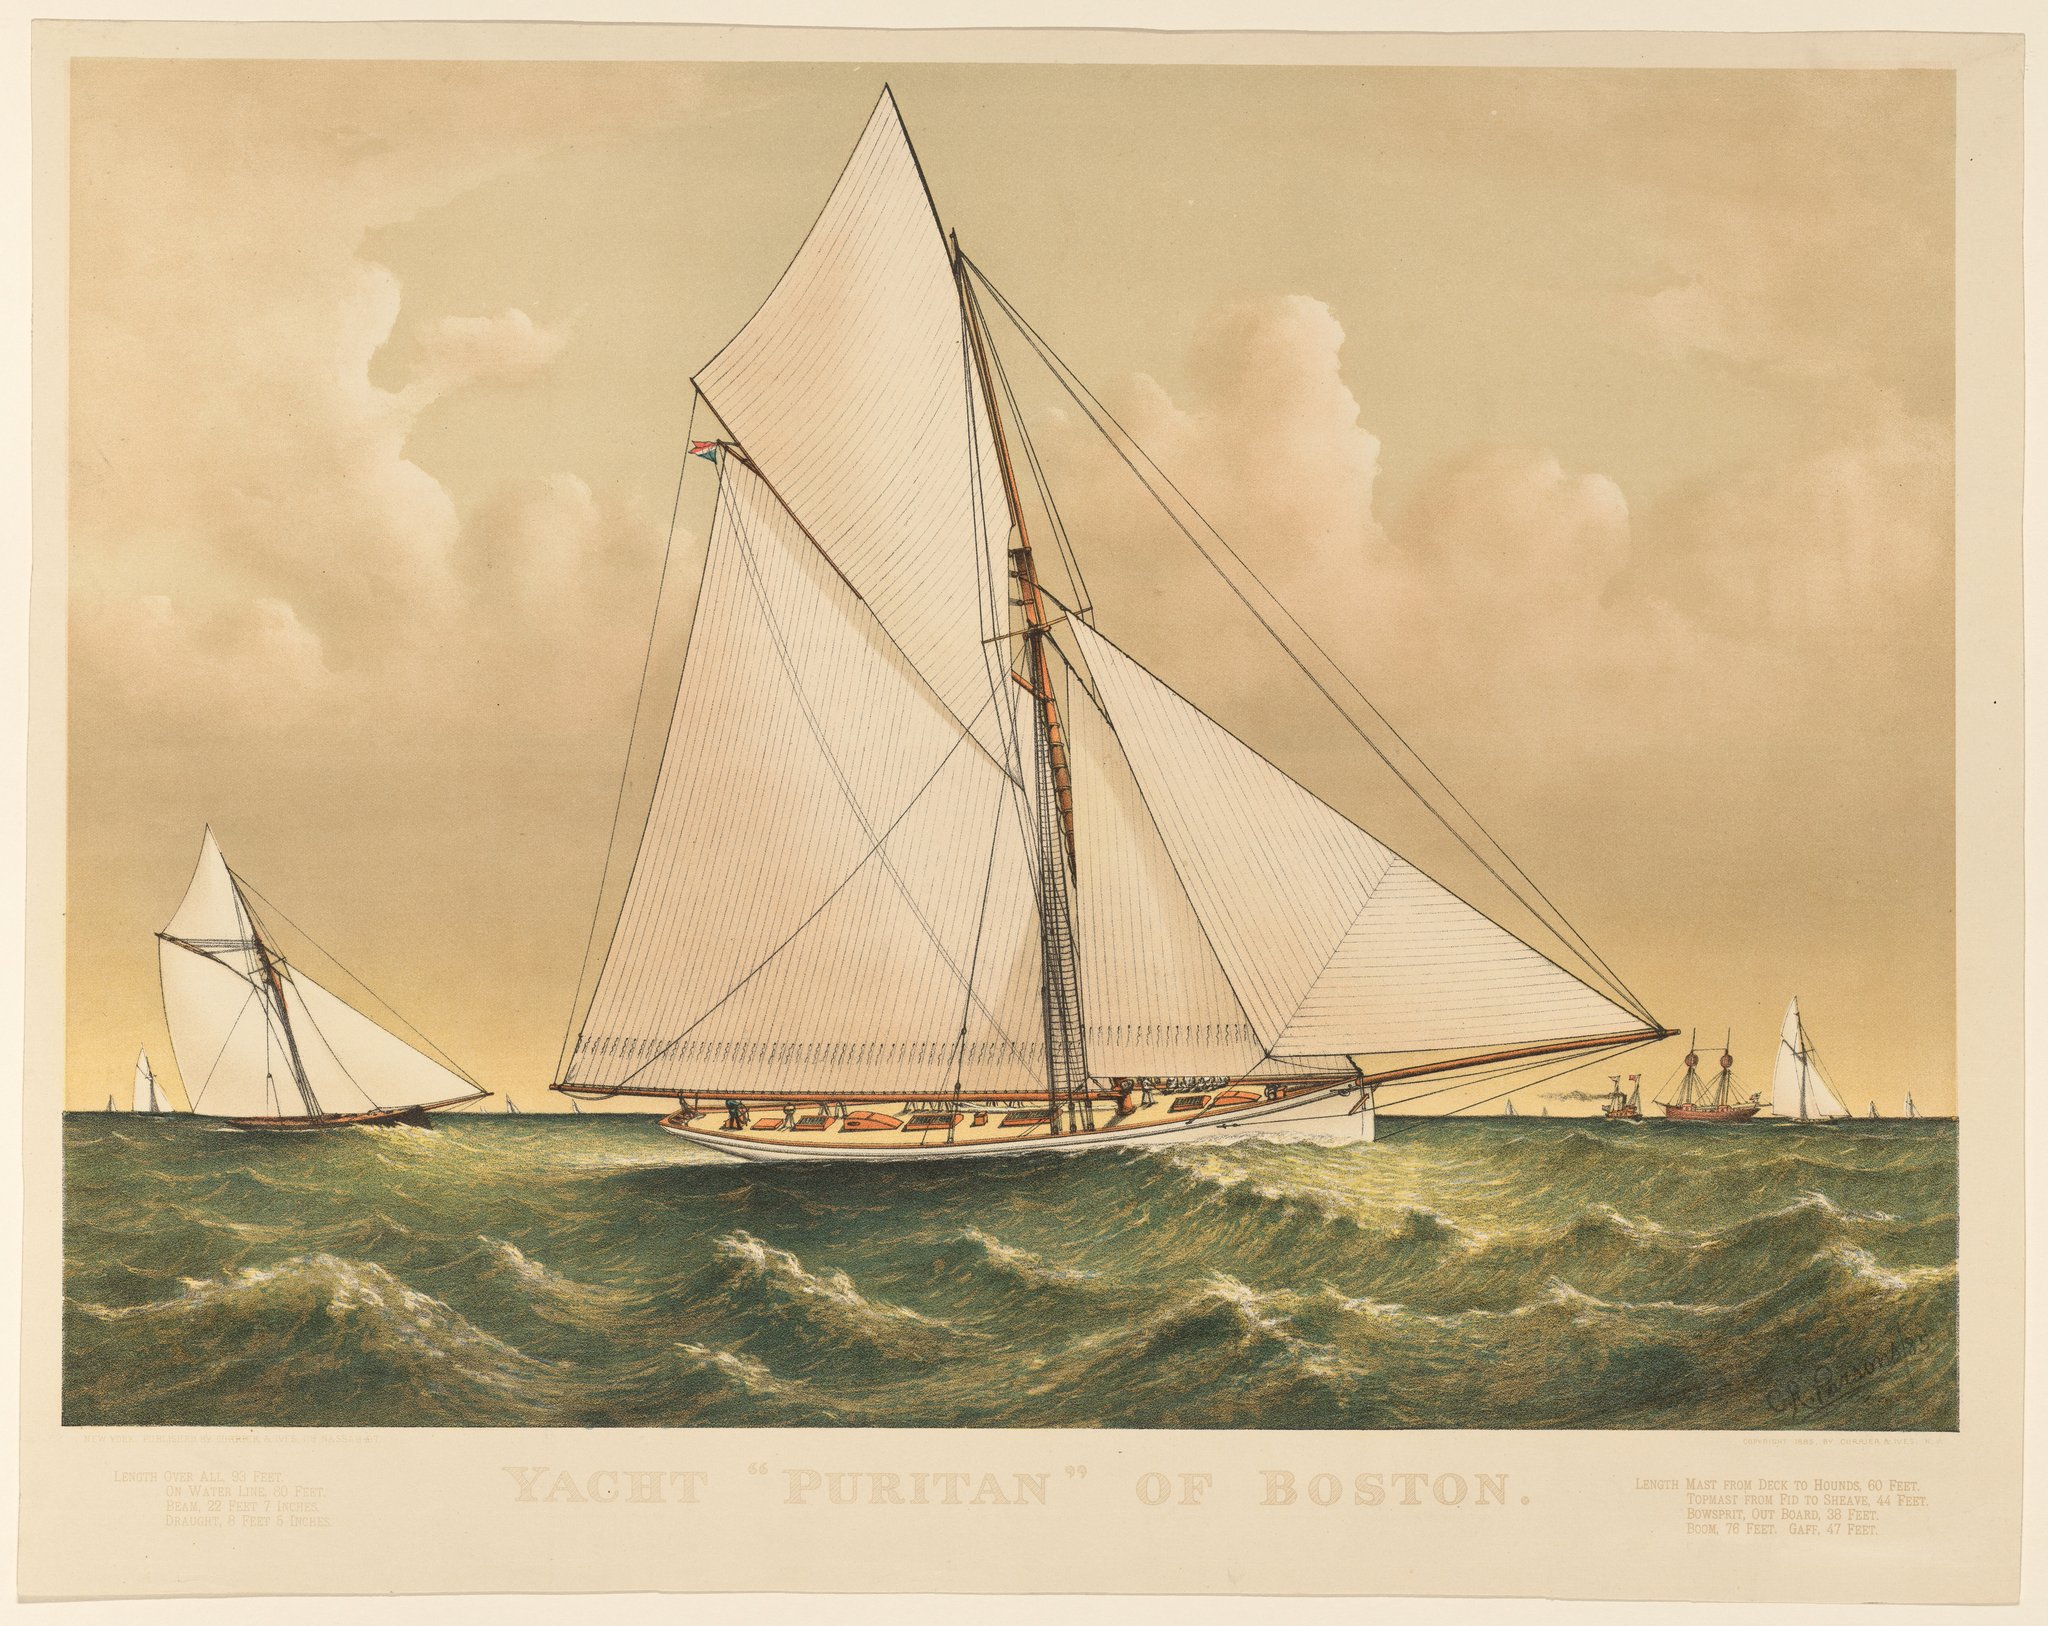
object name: print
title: Yacht "Puritan" of Boston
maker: charles richard parsons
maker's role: artist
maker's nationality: american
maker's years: 1844-1918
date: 1885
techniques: lithograph, printing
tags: boats